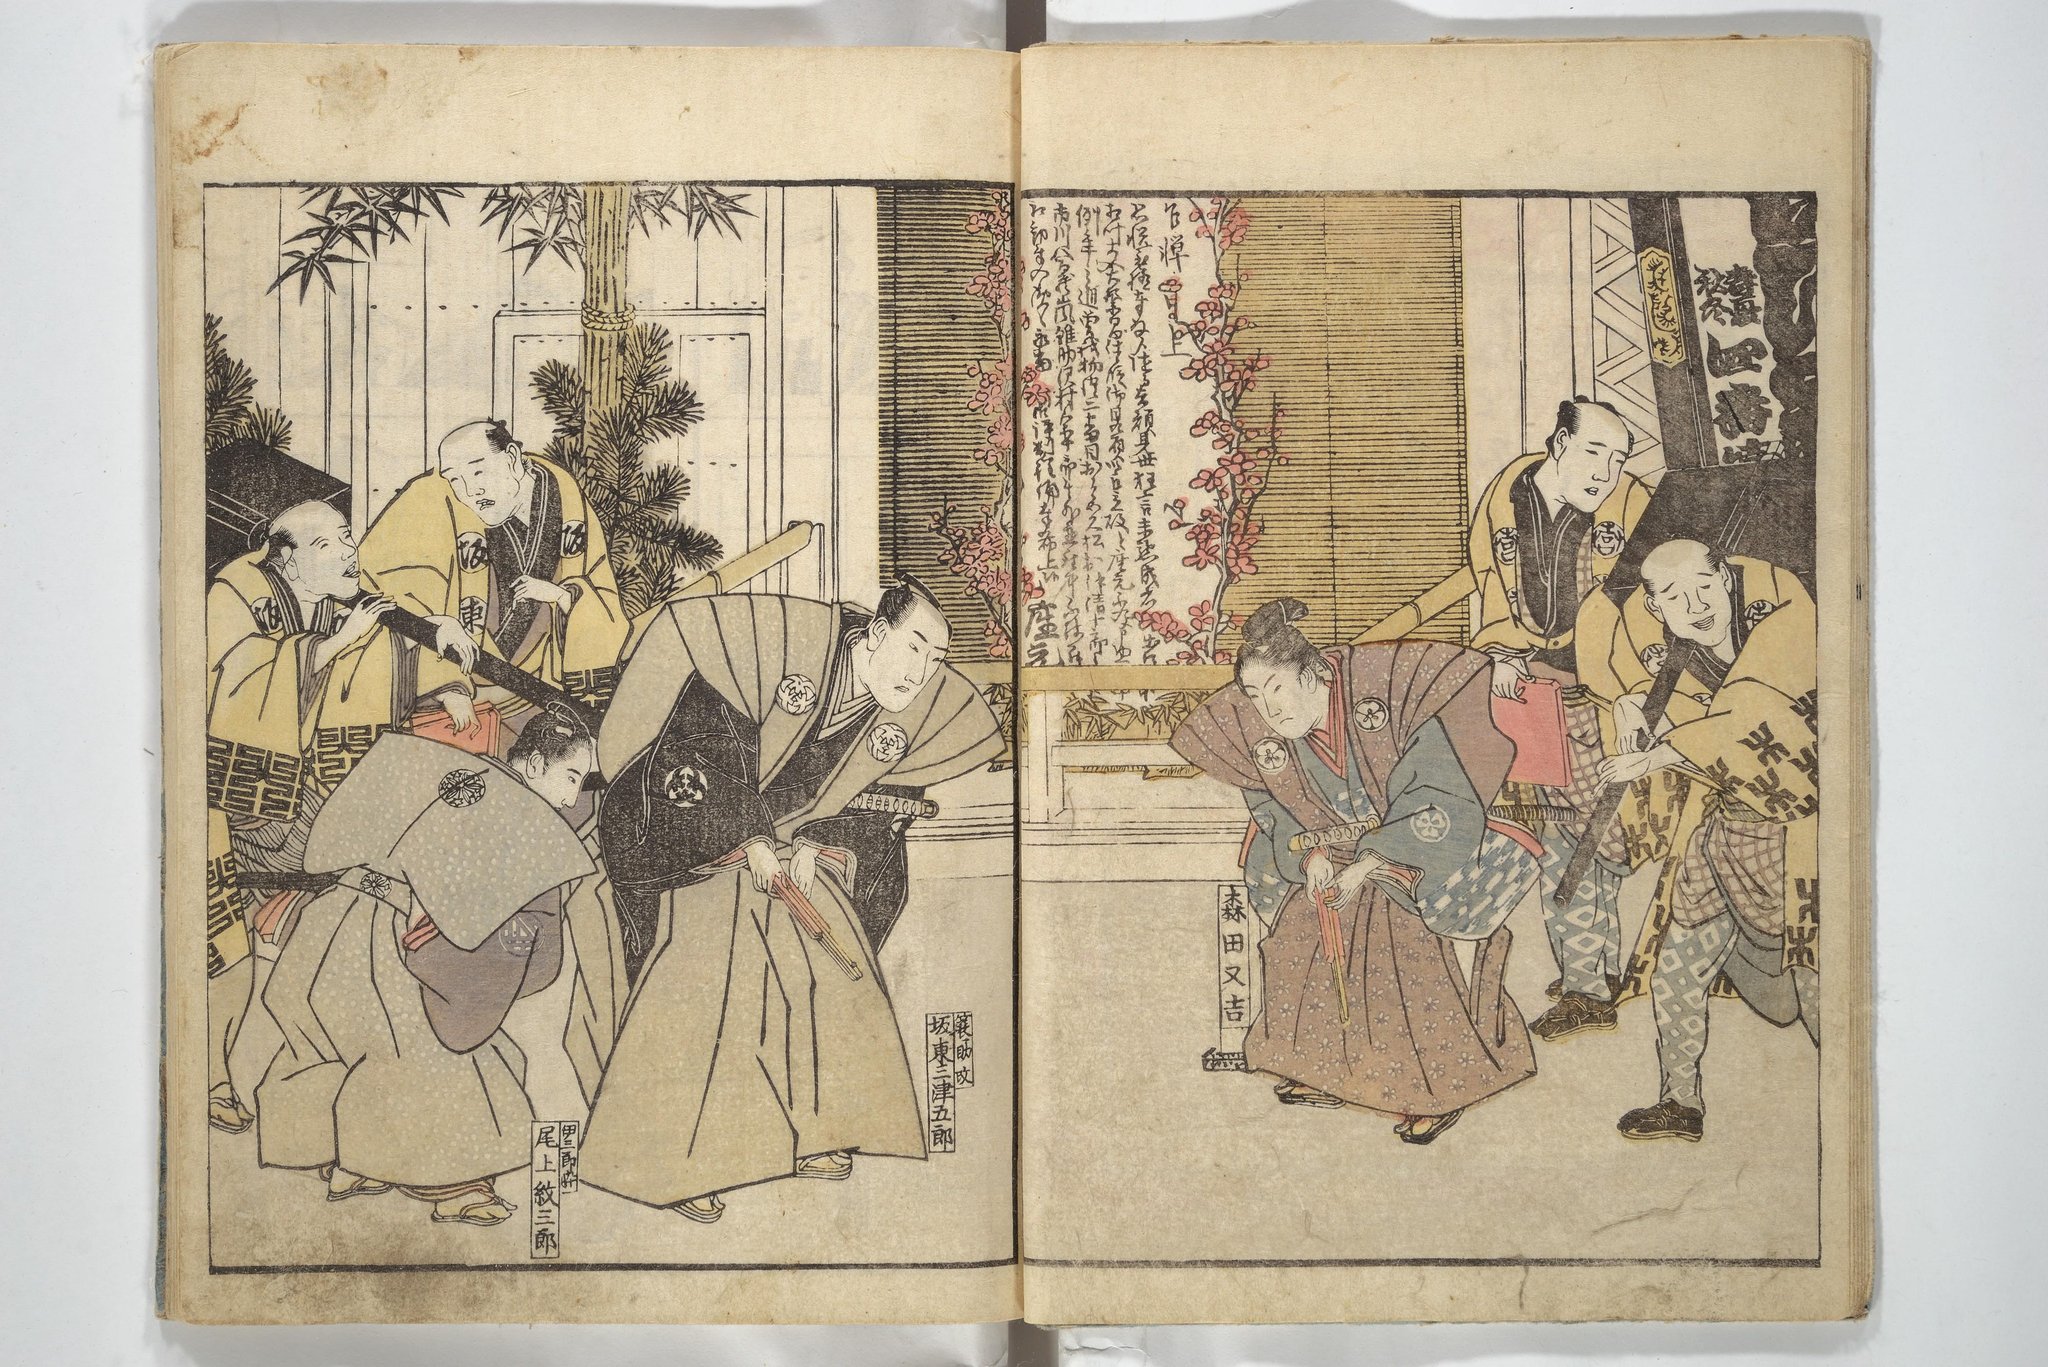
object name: illustrated book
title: Amusements of Kabuki Actors of the “Third Floor” [Dressing Room], by Shikitei Sanba 俳優三階興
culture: japanese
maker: utagawa toyokuni i 歌川豊国一世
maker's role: artist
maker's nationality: japanese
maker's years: 1769-1825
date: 1801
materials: ink, paper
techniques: woodblock print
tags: men,flowers,leaves,actors